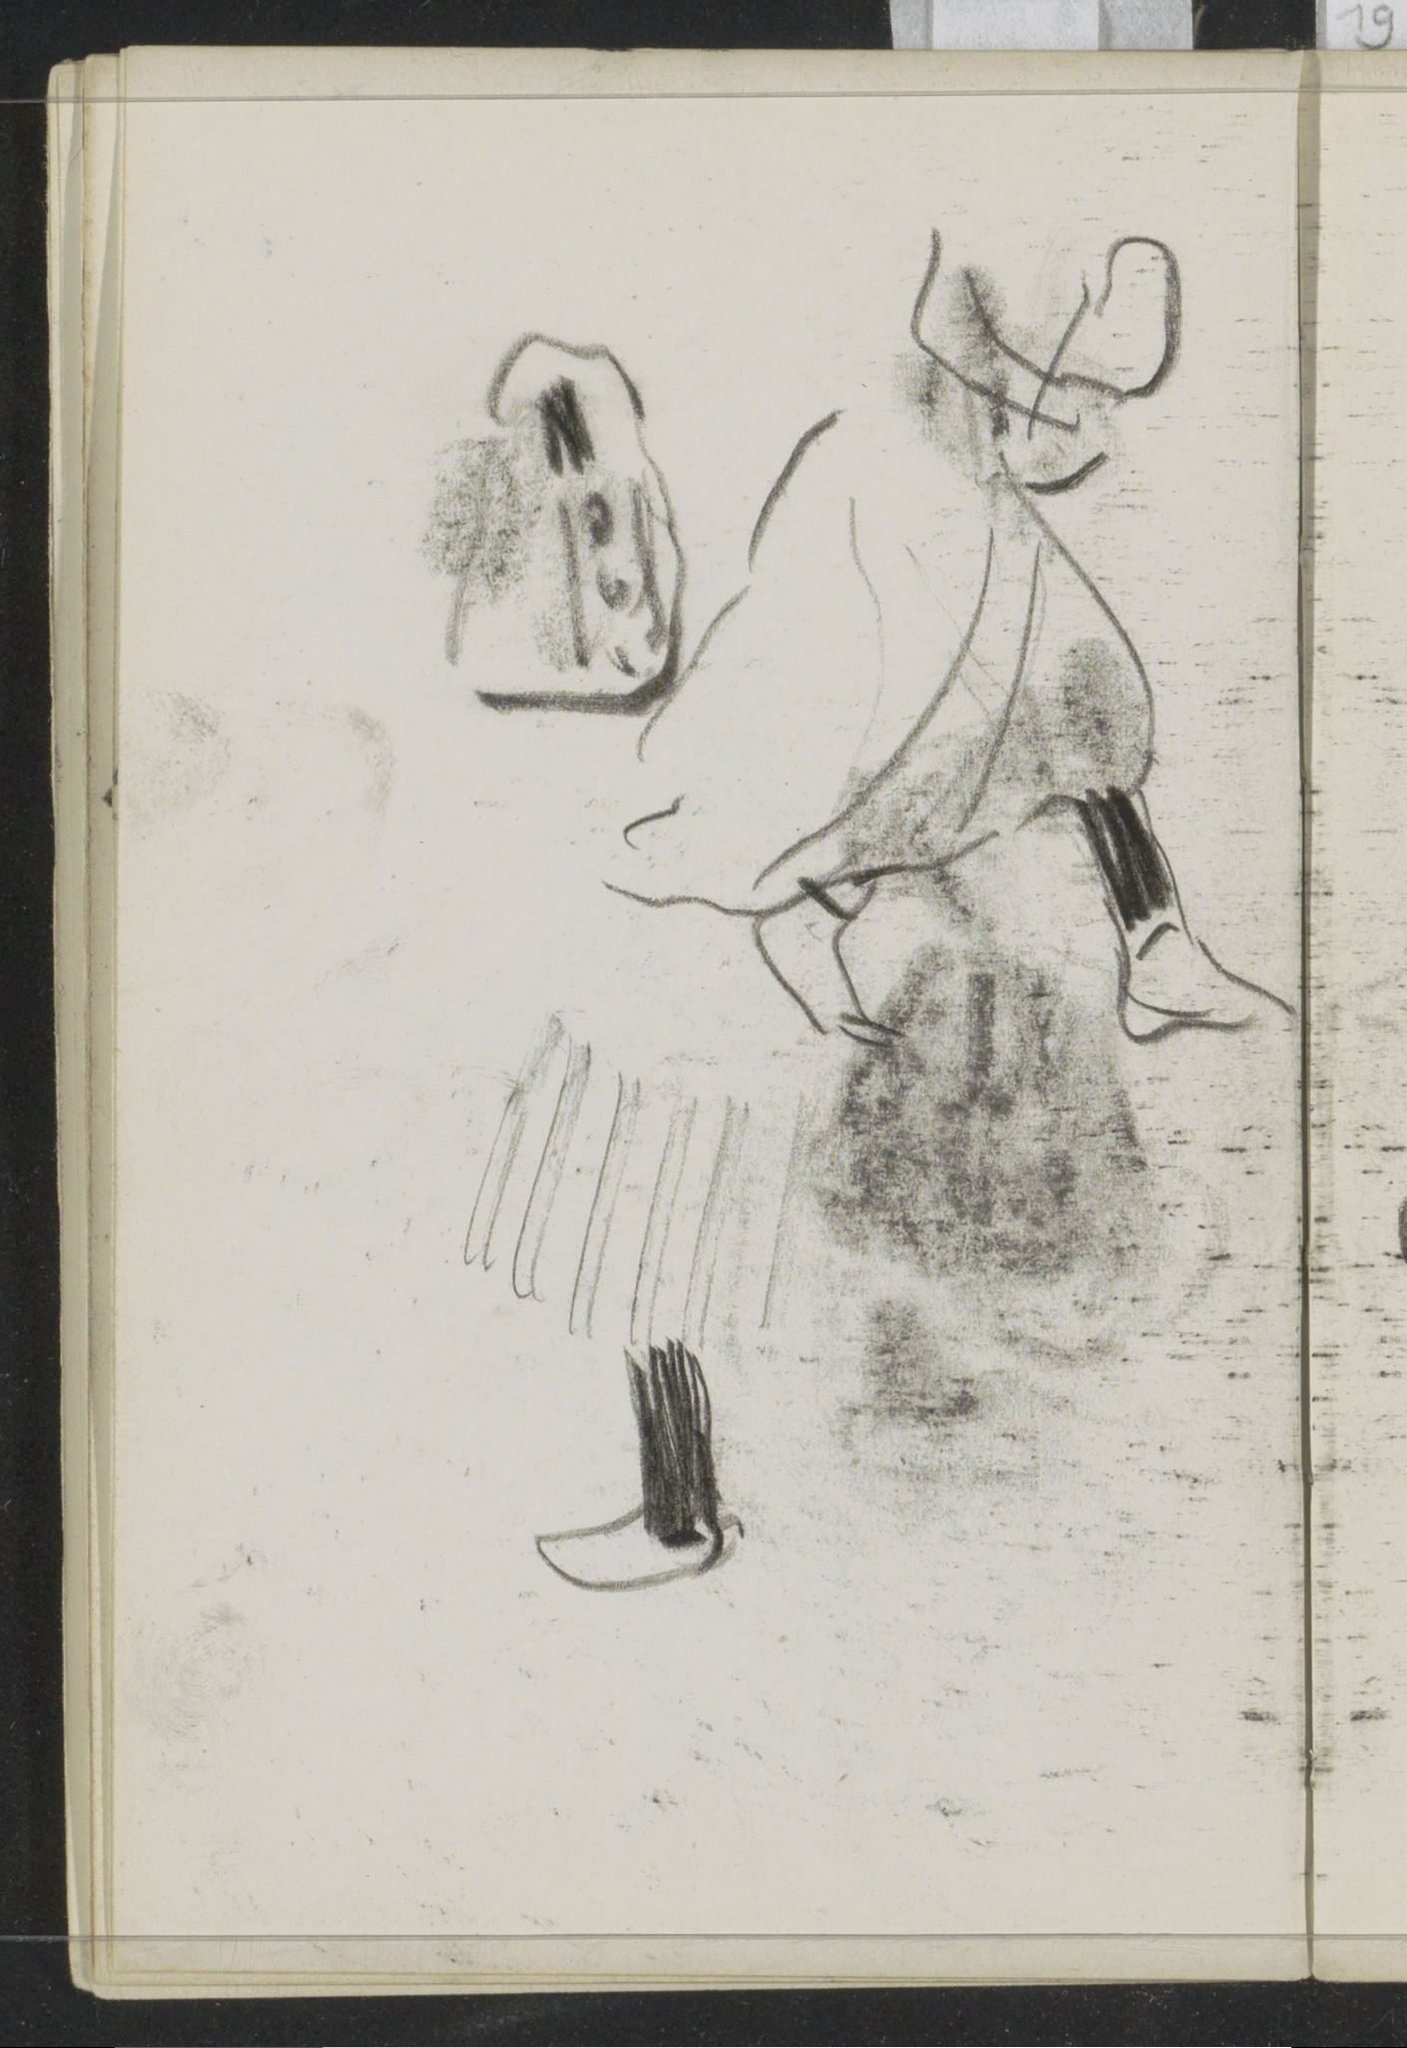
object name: sketchbook leaf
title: Lopende vrouw in een rok en een voet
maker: carel adolph lion cachet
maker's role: draughtsman, print maker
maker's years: 1864-1945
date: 1874-1945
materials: chalk, paper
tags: walking (+ female (human being) (not to be used where -aa- is prescribed)), foot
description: Blad 16 verso uit een schetsboek met 41 bladen.